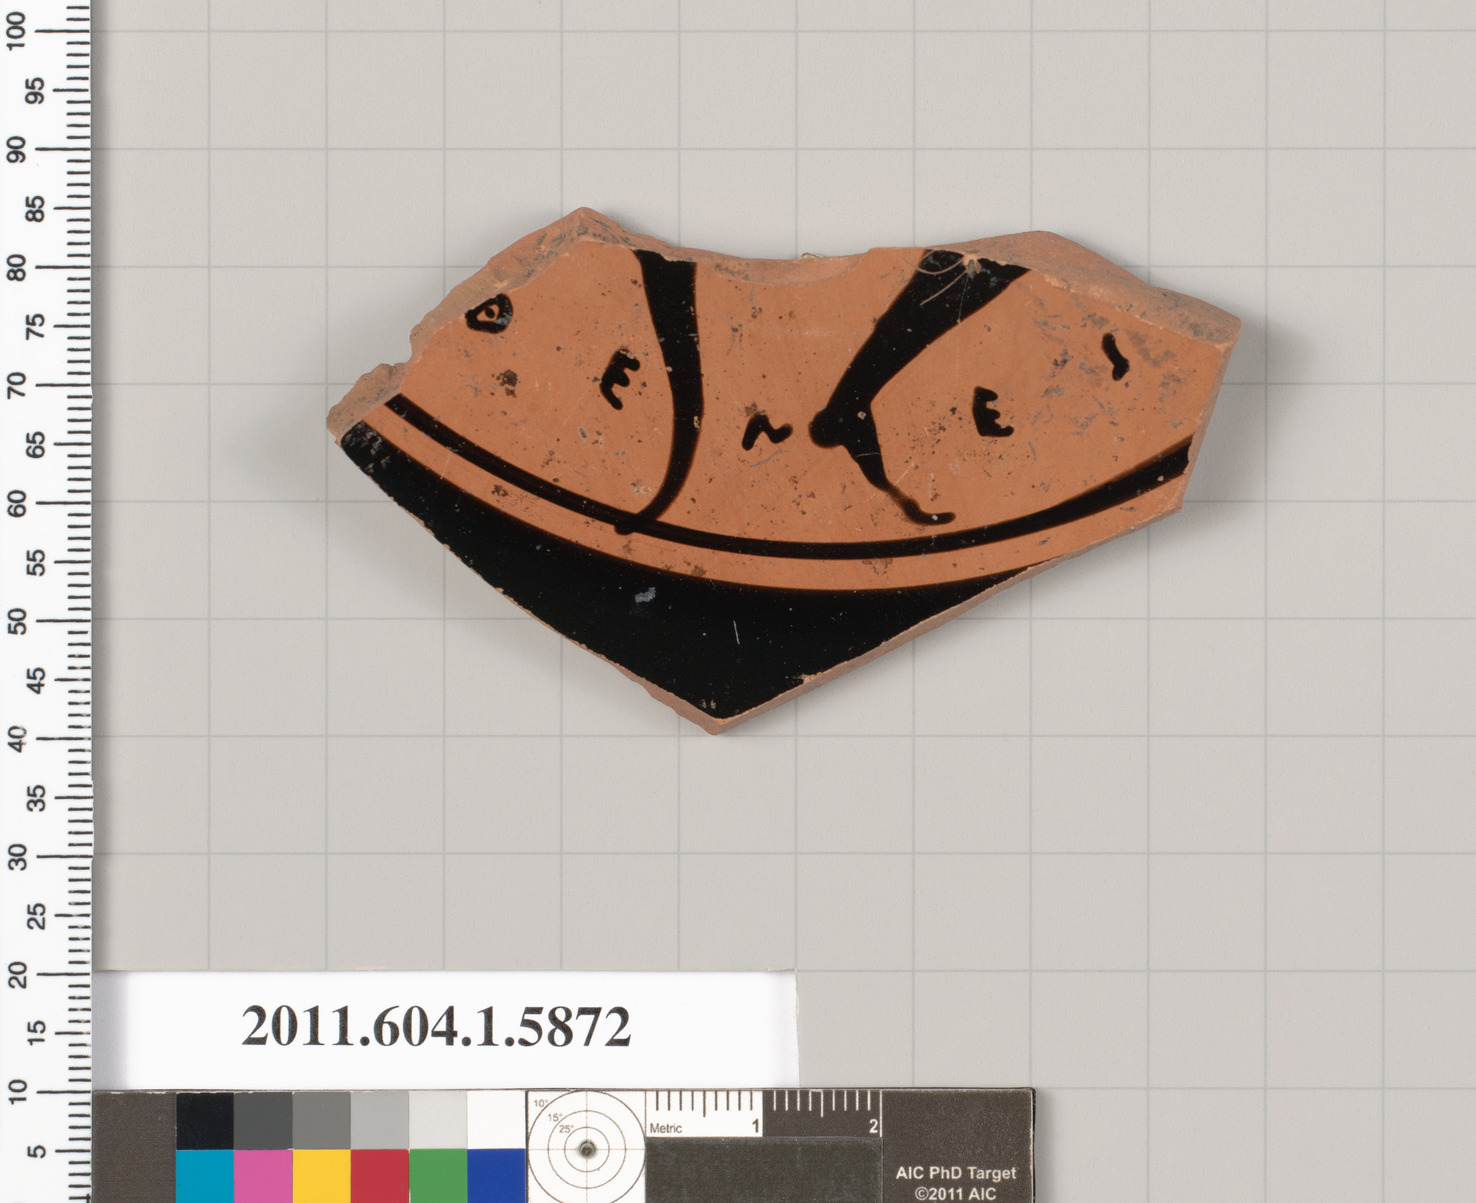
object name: kylix fragment, eye cup, bilingual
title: Terracotta fragment of a kylix (drinking cup)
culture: greek, attic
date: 433-567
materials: terracotta